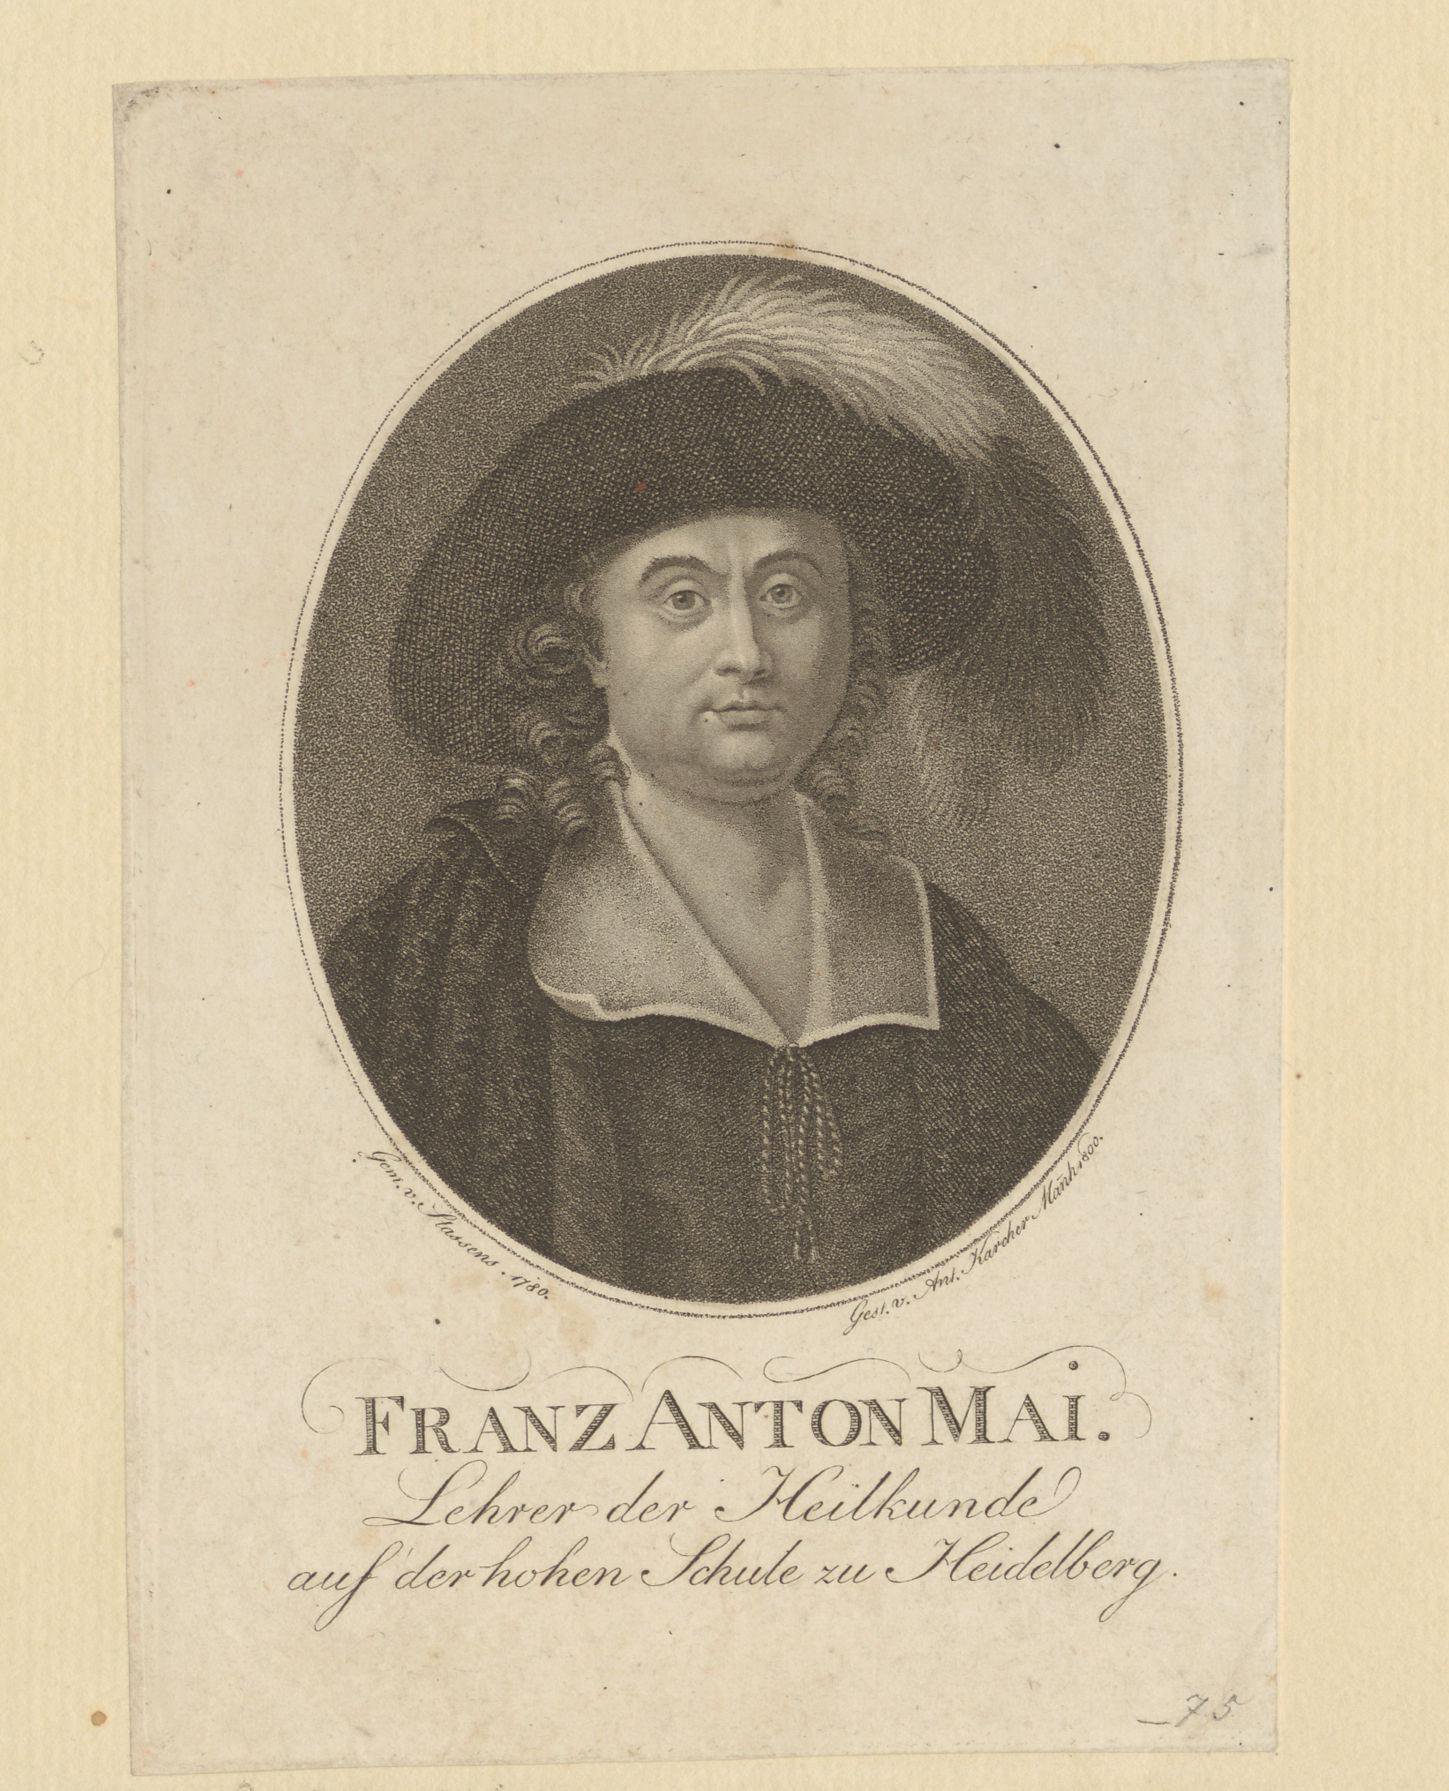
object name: print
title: Portret van Franz Anton May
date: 1800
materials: paper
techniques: stippling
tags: further education (+ portrait of teacher, professor), historical persons, physician, doctor (+ portrait of scholar, scientist)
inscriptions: collector's mark: Lugt 2228